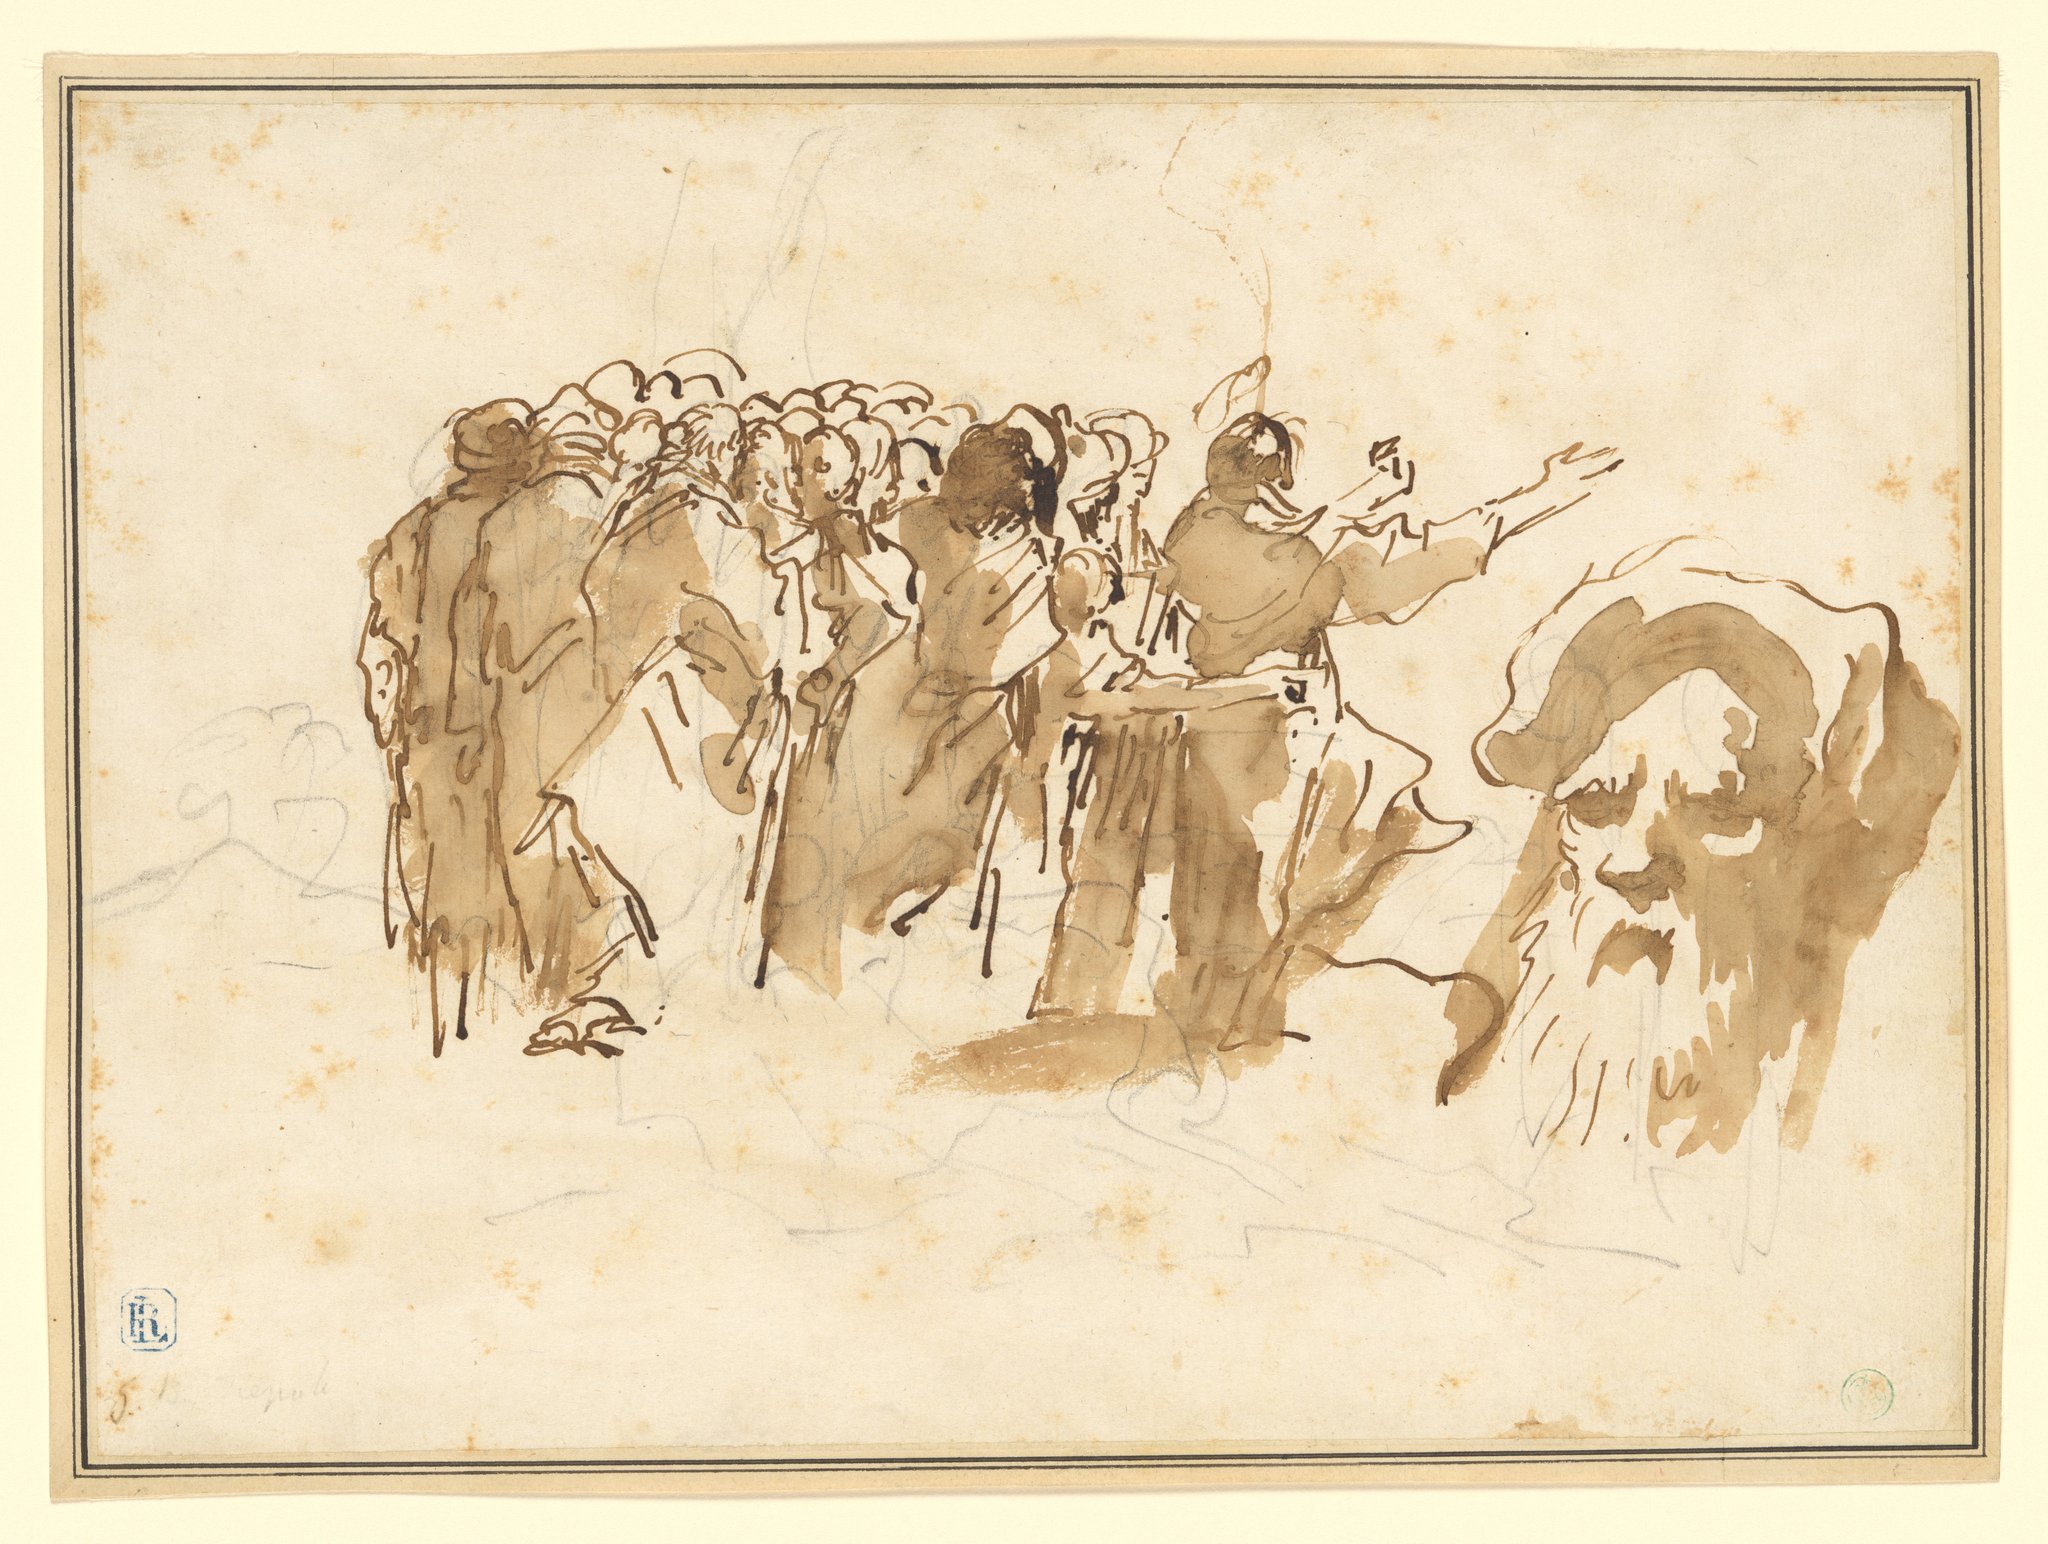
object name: drawing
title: A Saint Preaching, and the Head of an Oriental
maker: giovanni domenico tiepolo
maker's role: artist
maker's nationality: italian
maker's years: 1727-1804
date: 1759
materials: chalk, ink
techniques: pen, wash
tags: heads,men,saints